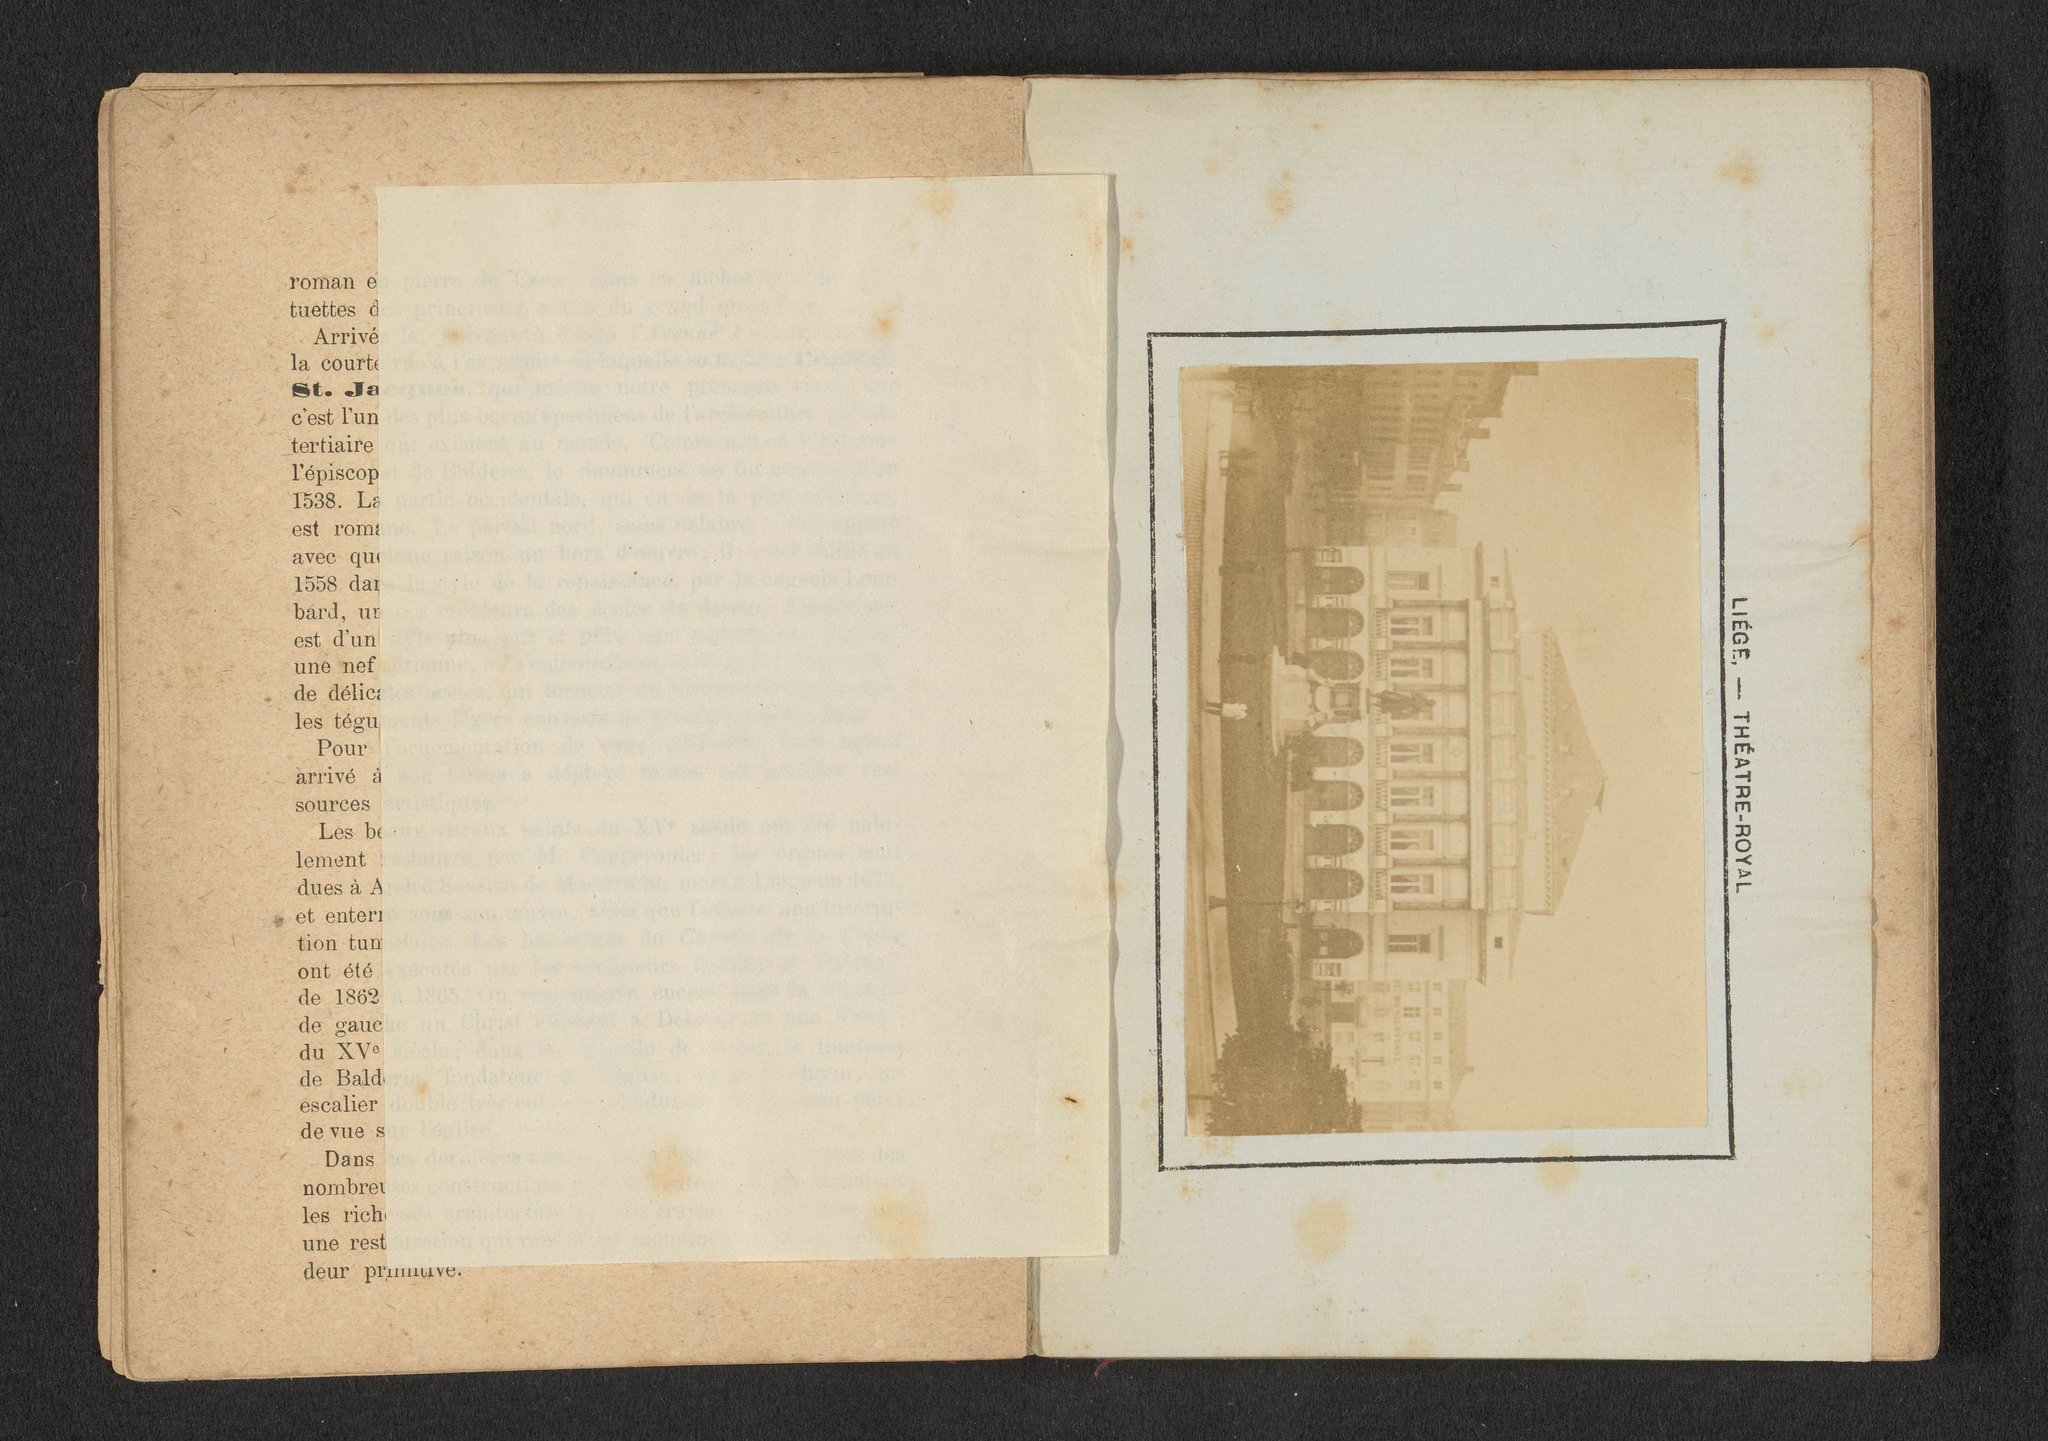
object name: photograph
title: Liège, Théatre Royal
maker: Anonymous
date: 1876-1881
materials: photographic support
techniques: albumen print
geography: liège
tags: opera house, liège